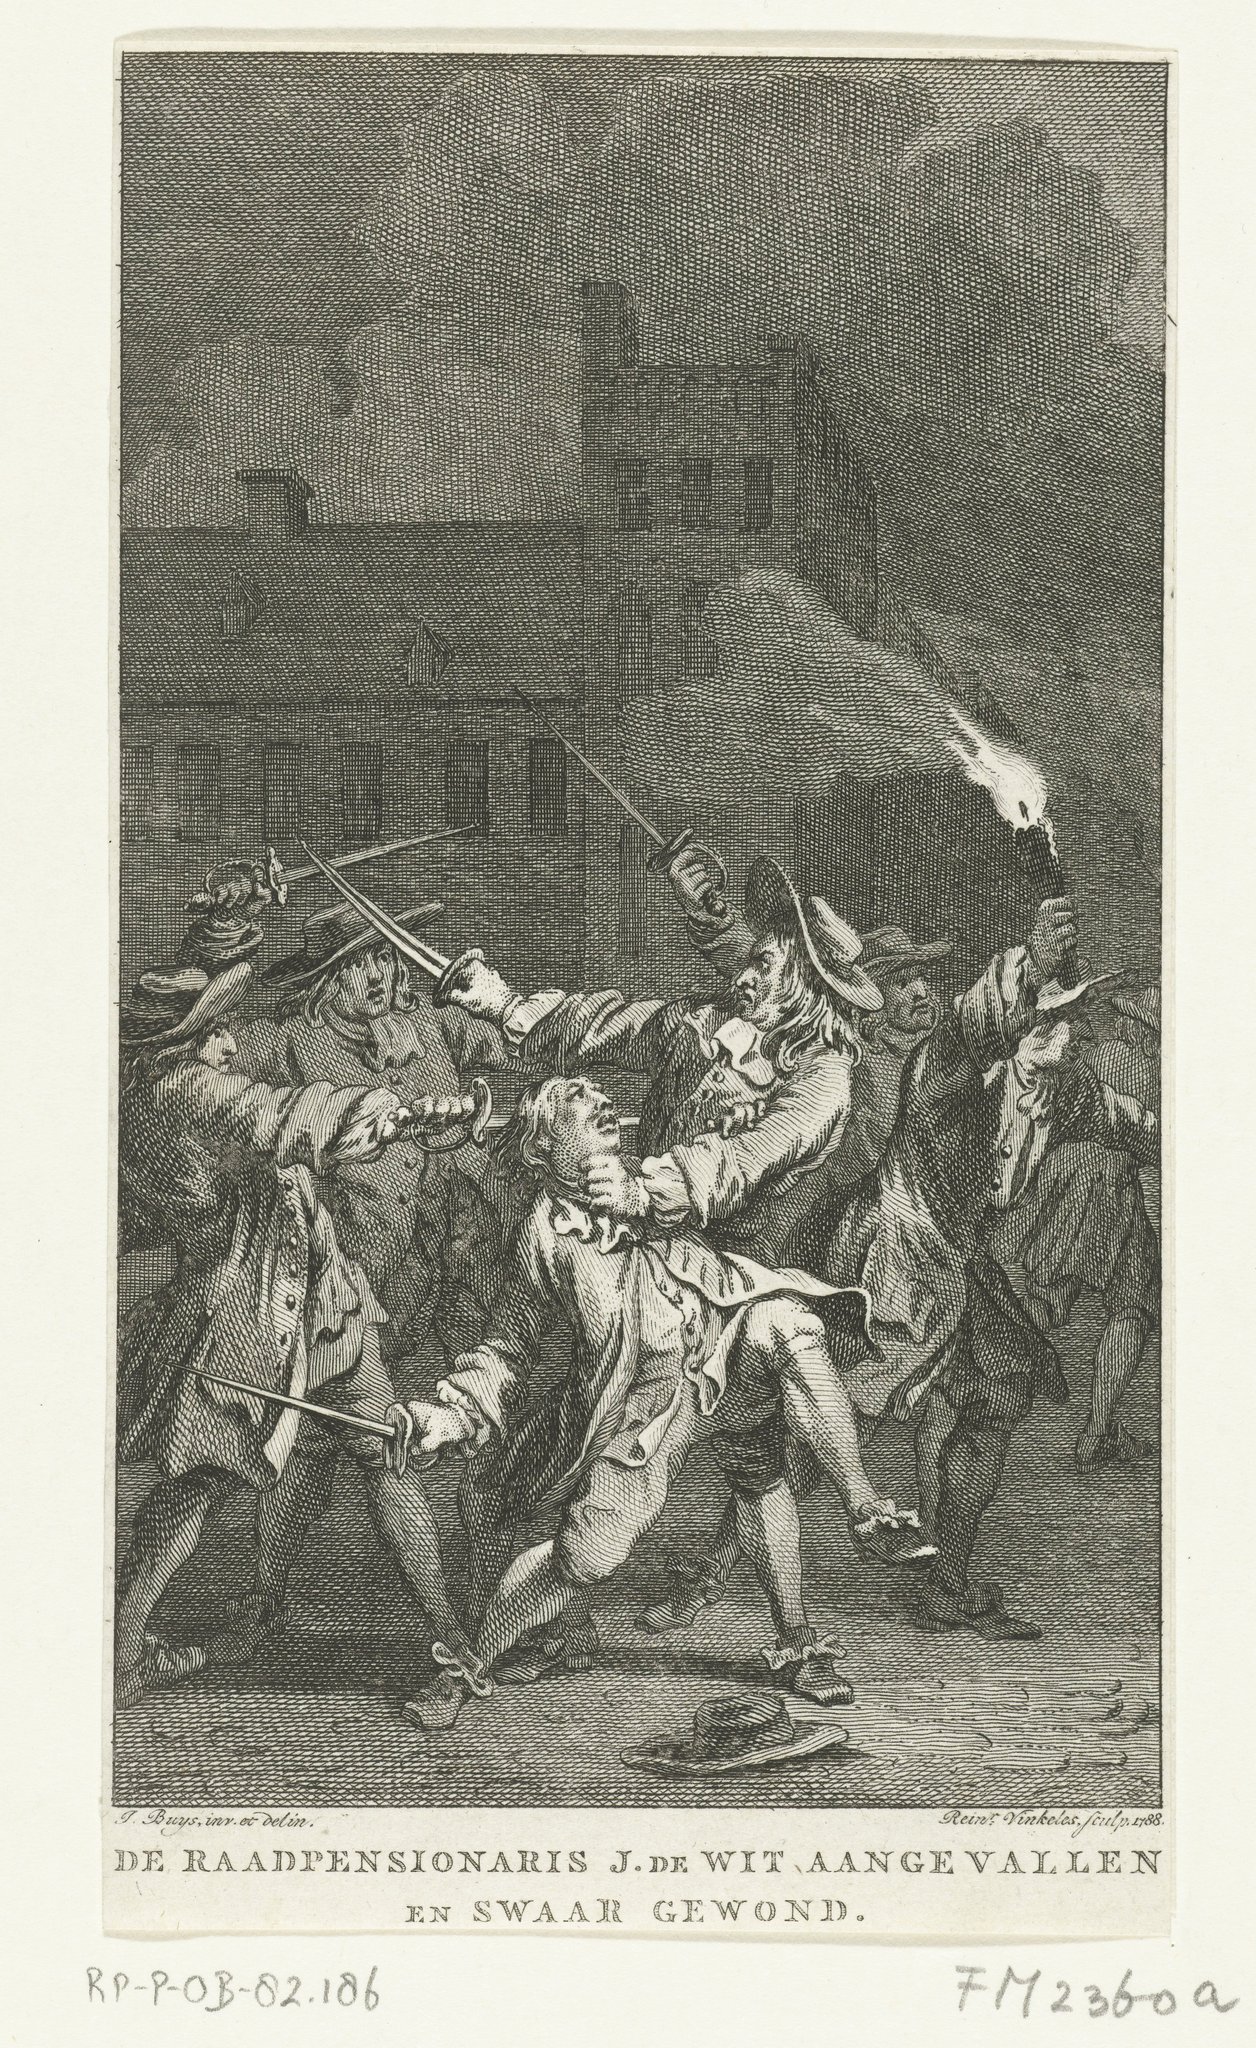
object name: print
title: De raadpensionaris J. de Wit aangevallen en swaar gewond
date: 1788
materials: paper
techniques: etching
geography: netherlands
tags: the hague, politician, johan de witt, fighting, rampjaar (disaster year)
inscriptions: date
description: Gebruikt als illustratie in: Jacobus Kok, Vaderlandsch Woordenboek, Johannes Allart, Amsterdam 1785-1799, 35 delen, dl. XVIII, pl. V.